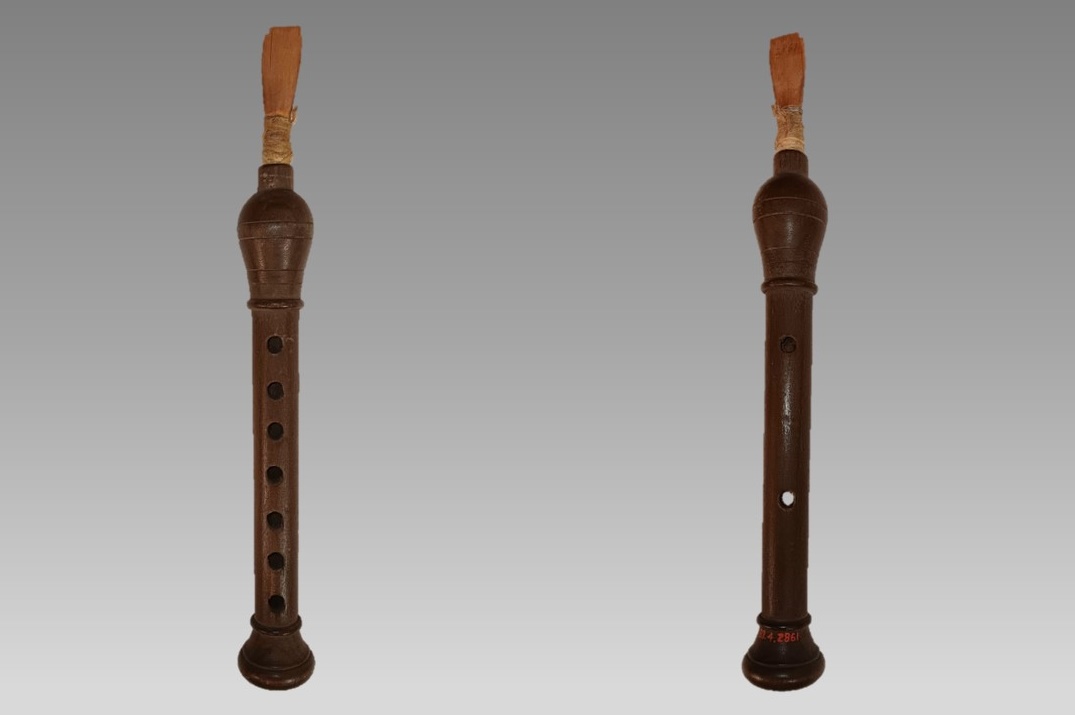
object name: e'raqyeh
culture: egyptian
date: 1850-1889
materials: wood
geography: egypt